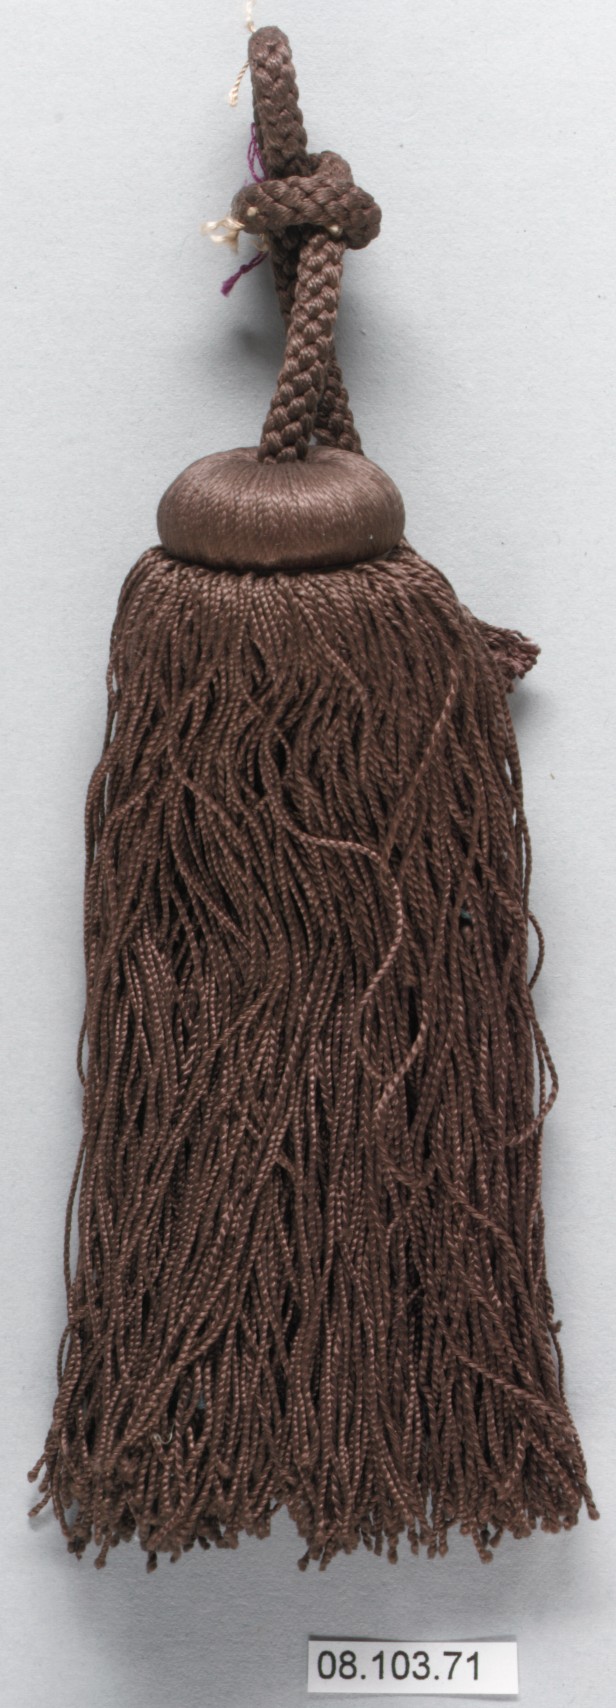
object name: tassel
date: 1801-1900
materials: silk